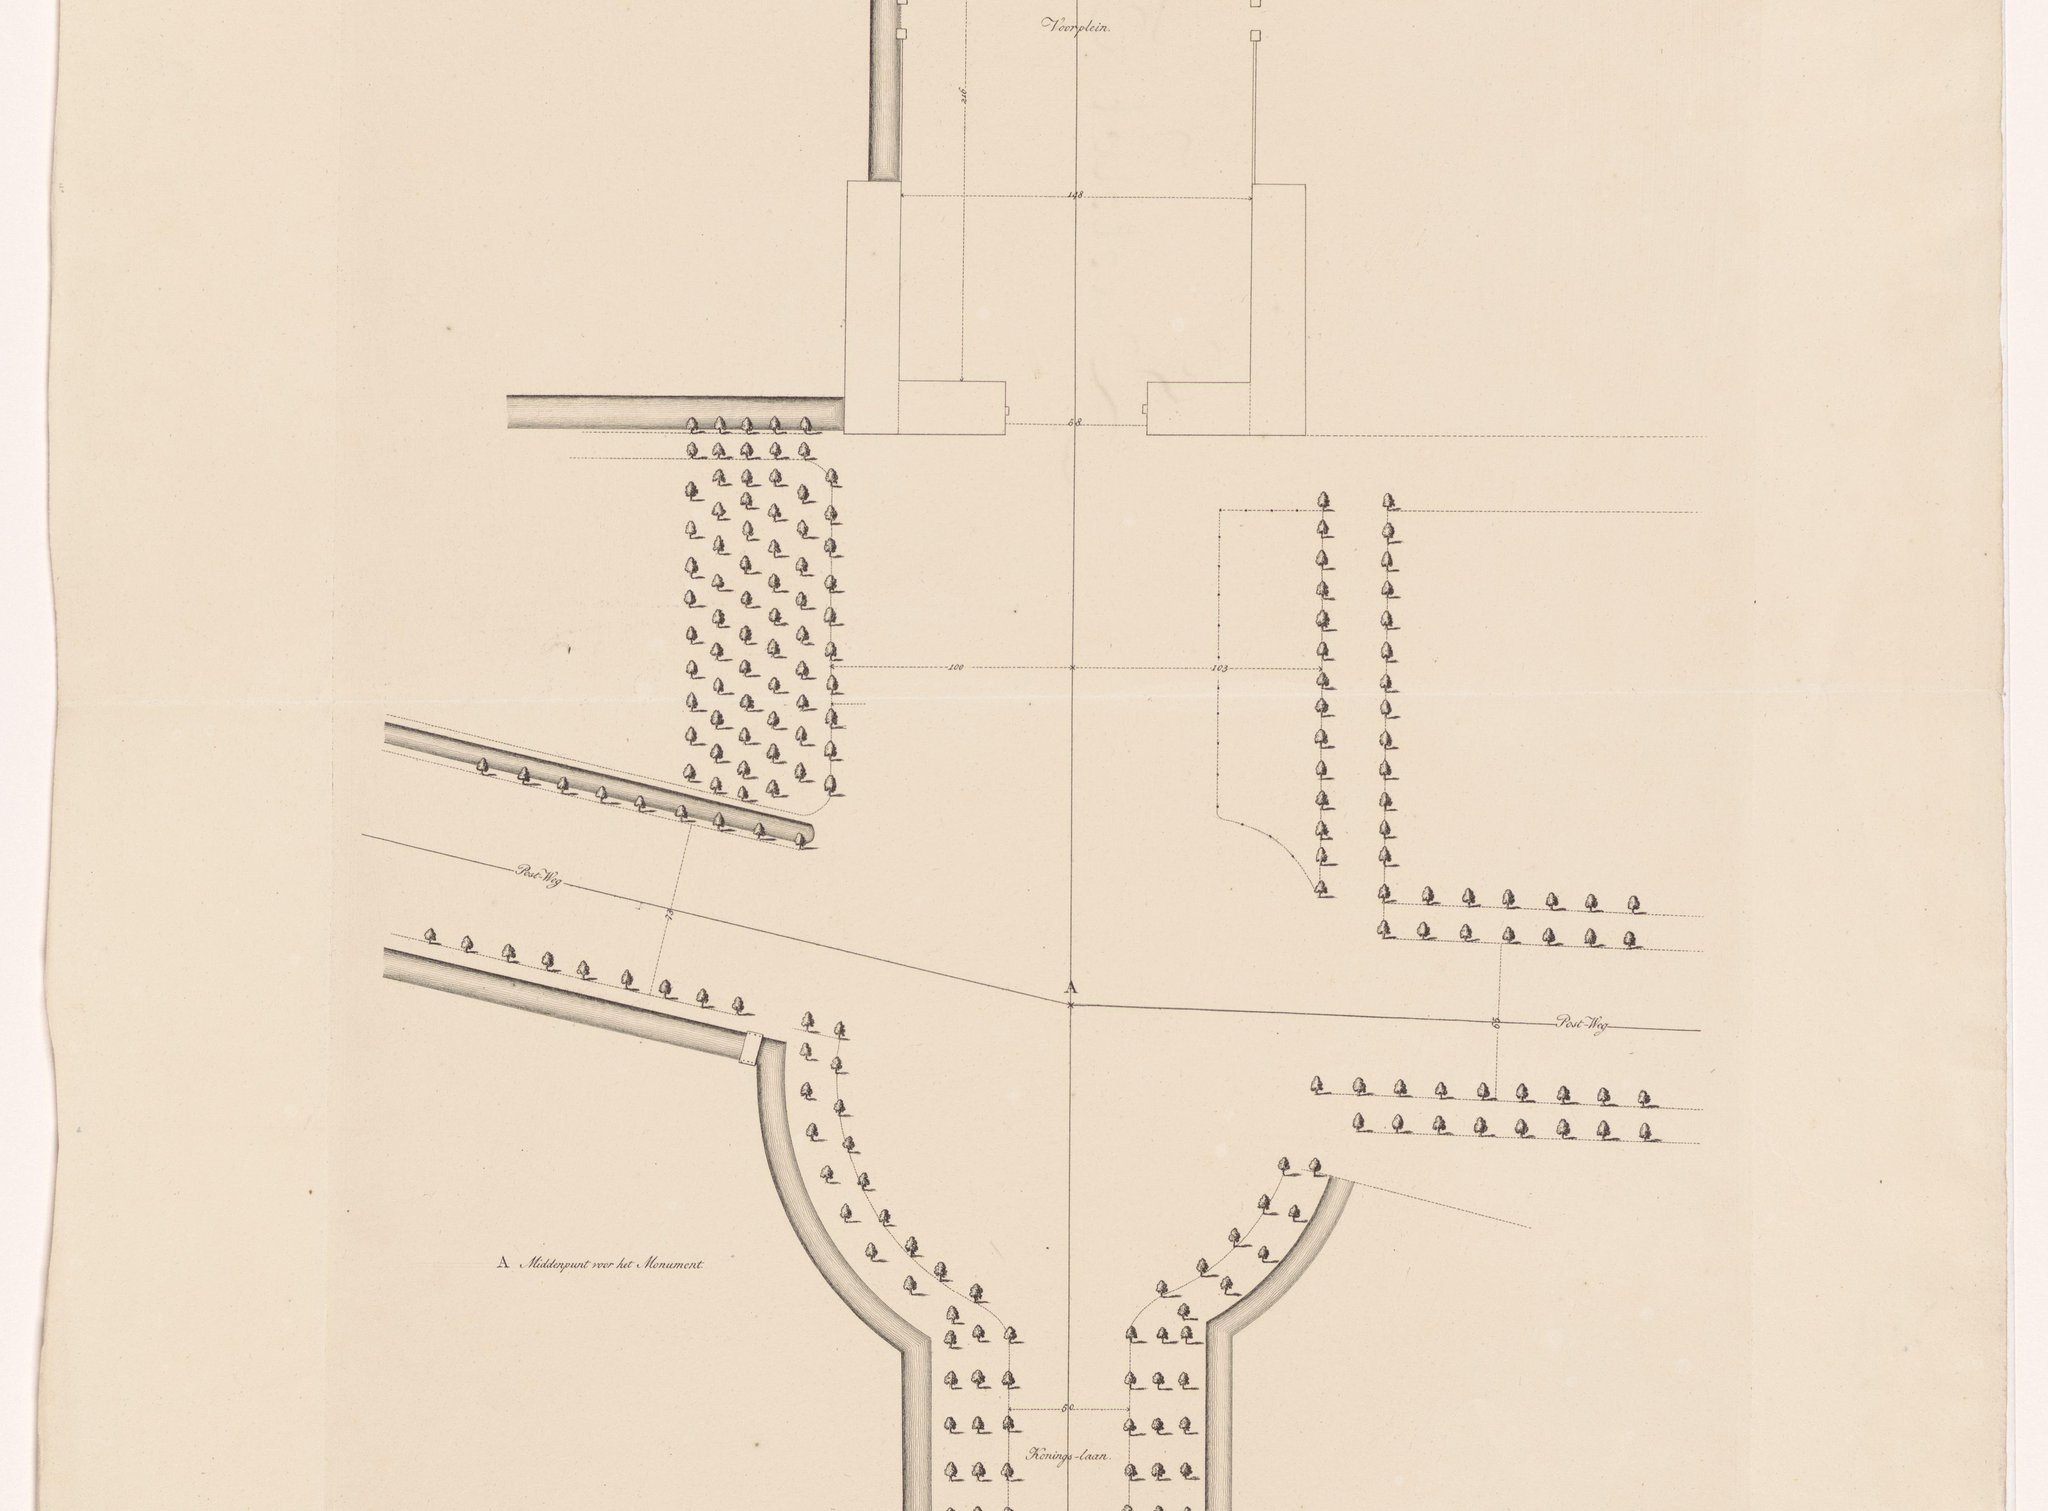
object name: print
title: Plattegrond van Paleis Soestdijk en voorliggende lanen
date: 1815-1868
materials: paper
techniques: engraving, etching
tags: maps of cities, hunting-seat, hunting lodge, 'rendez-vous de chasse', 'jagdschloss'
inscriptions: inscription: ‘Lustslot Soestdijk’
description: Onderaan een schaalstok: Rynl. voetmaat.